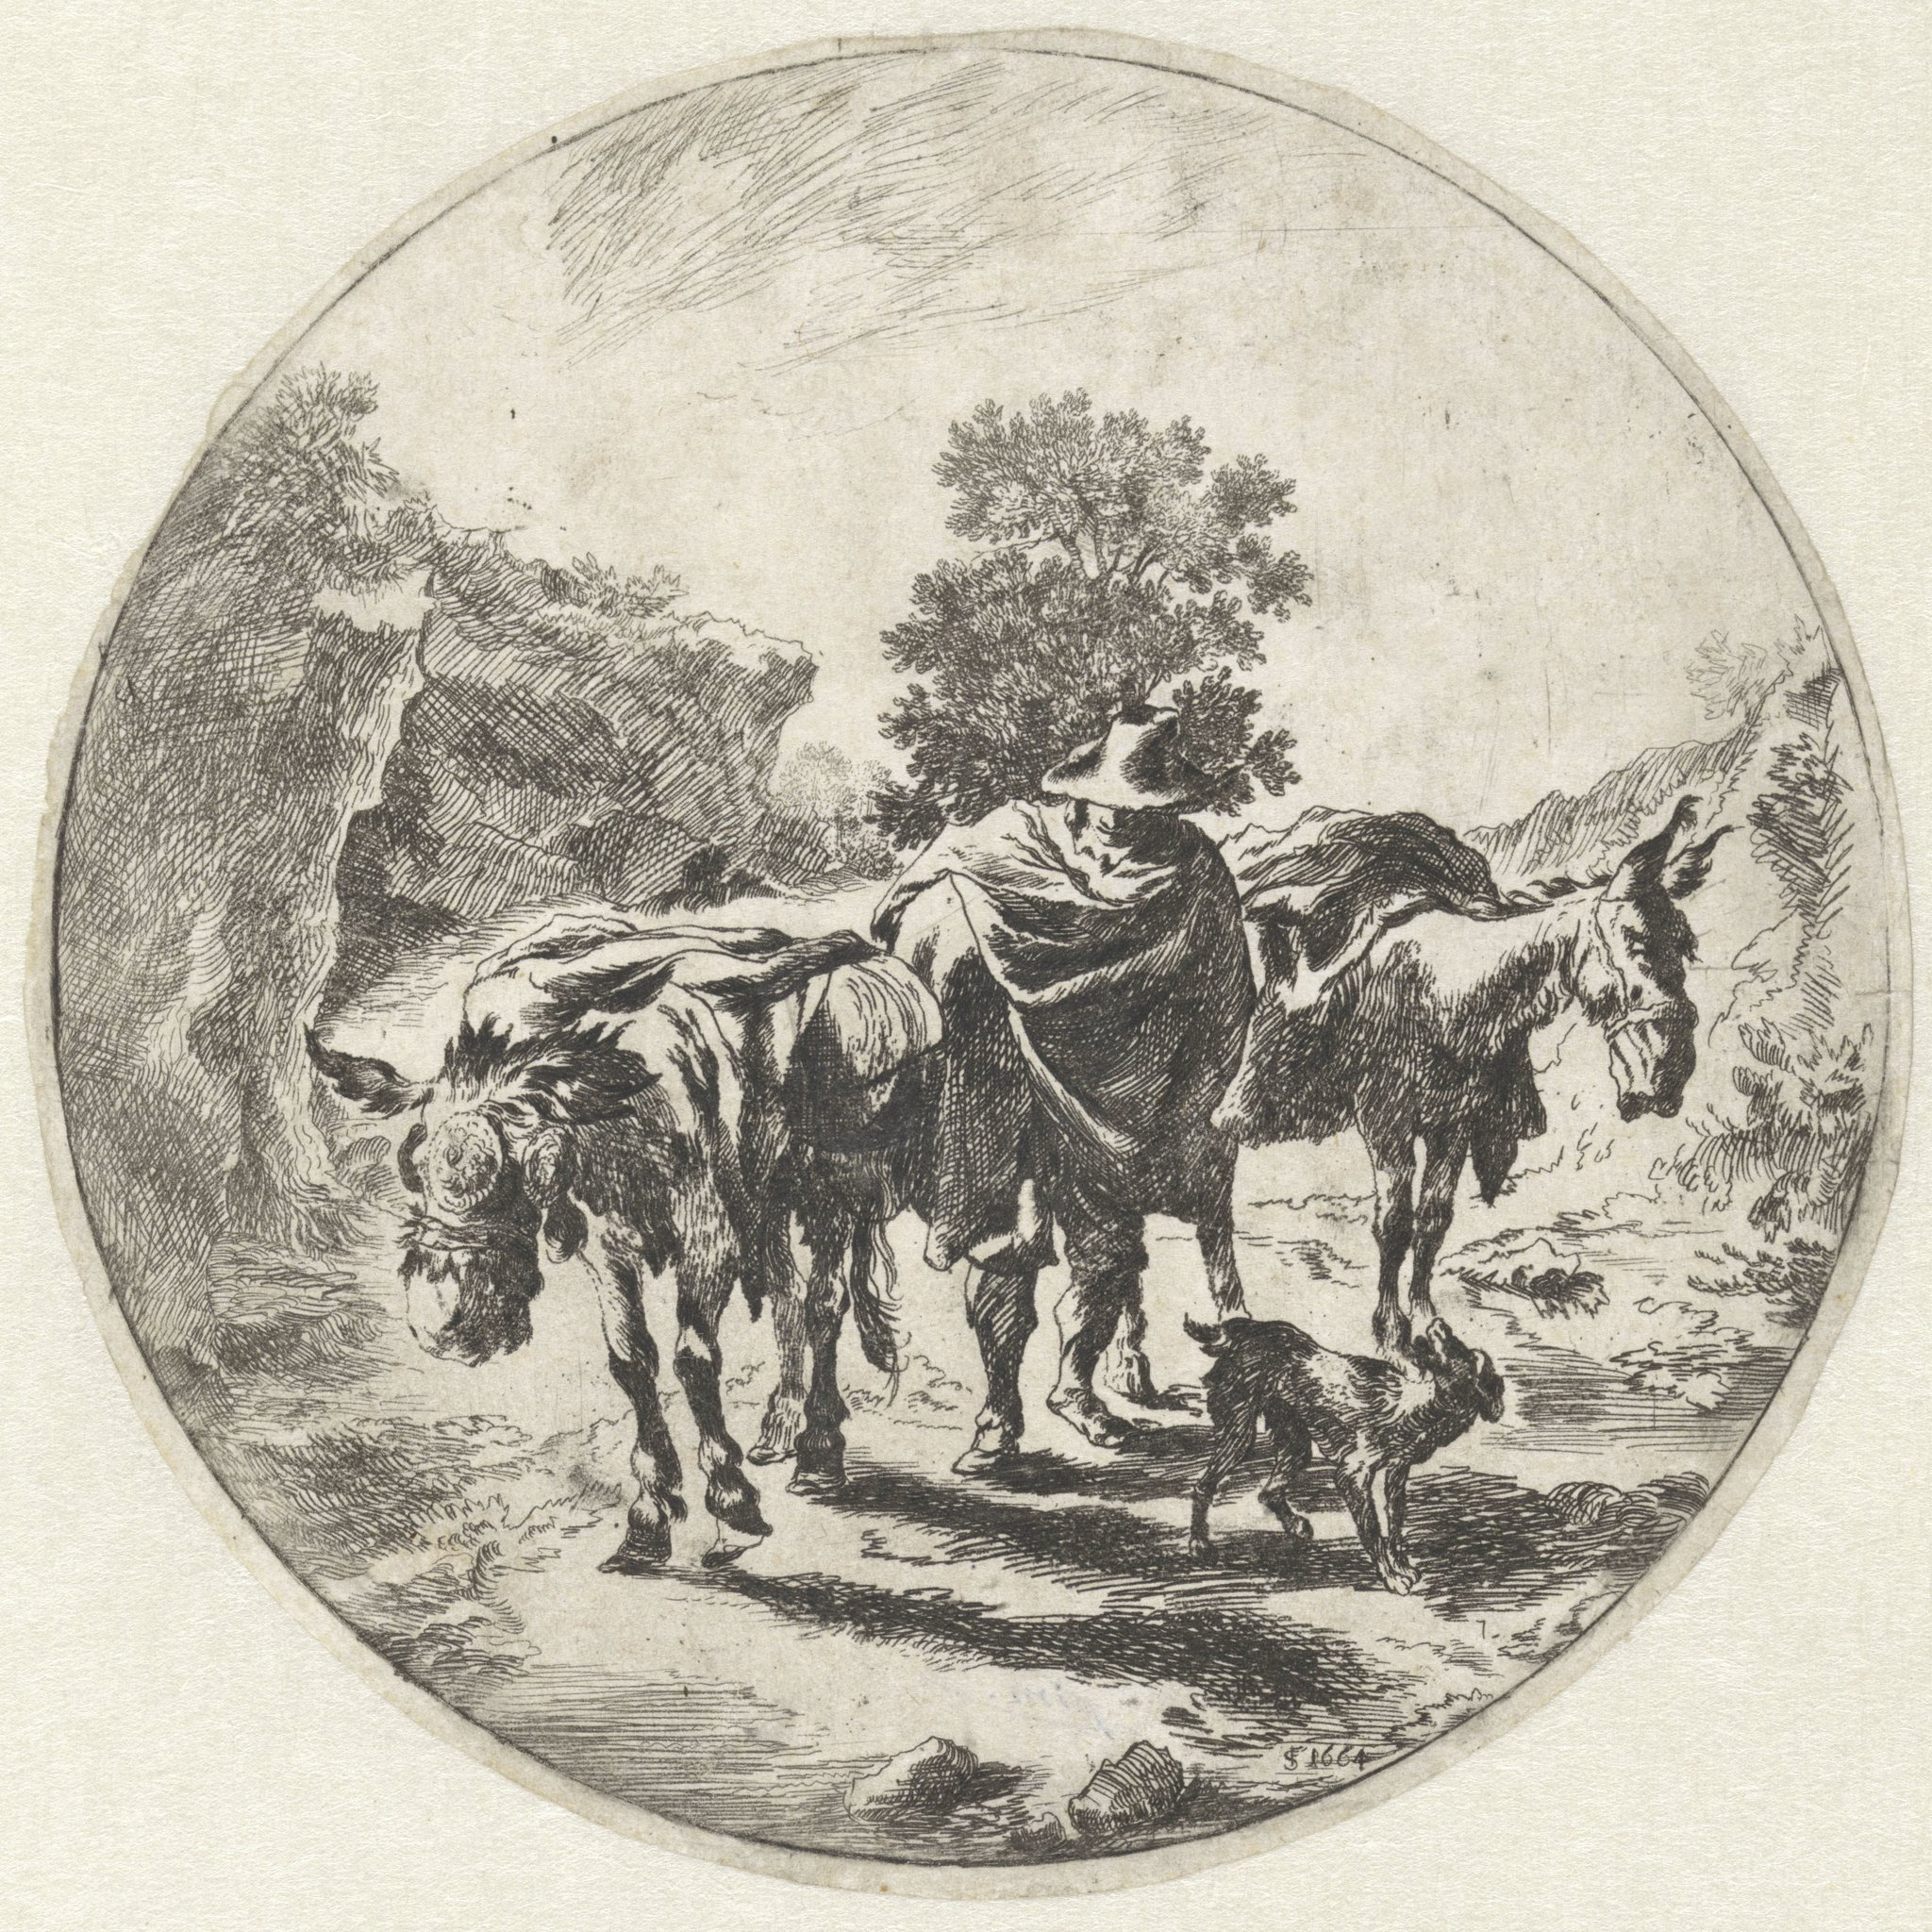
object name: print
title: Man met ezels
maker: jan frans soolmaker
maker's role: draughtsman, print maker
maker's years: 1635-1685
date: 1664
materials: paper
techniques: etching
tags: ass, donkey, dog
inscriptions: collector's mark: Lugt 269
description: In een bergachtig landschap loopt een man met twee bepakte ezels. Voor hem loopt een hond